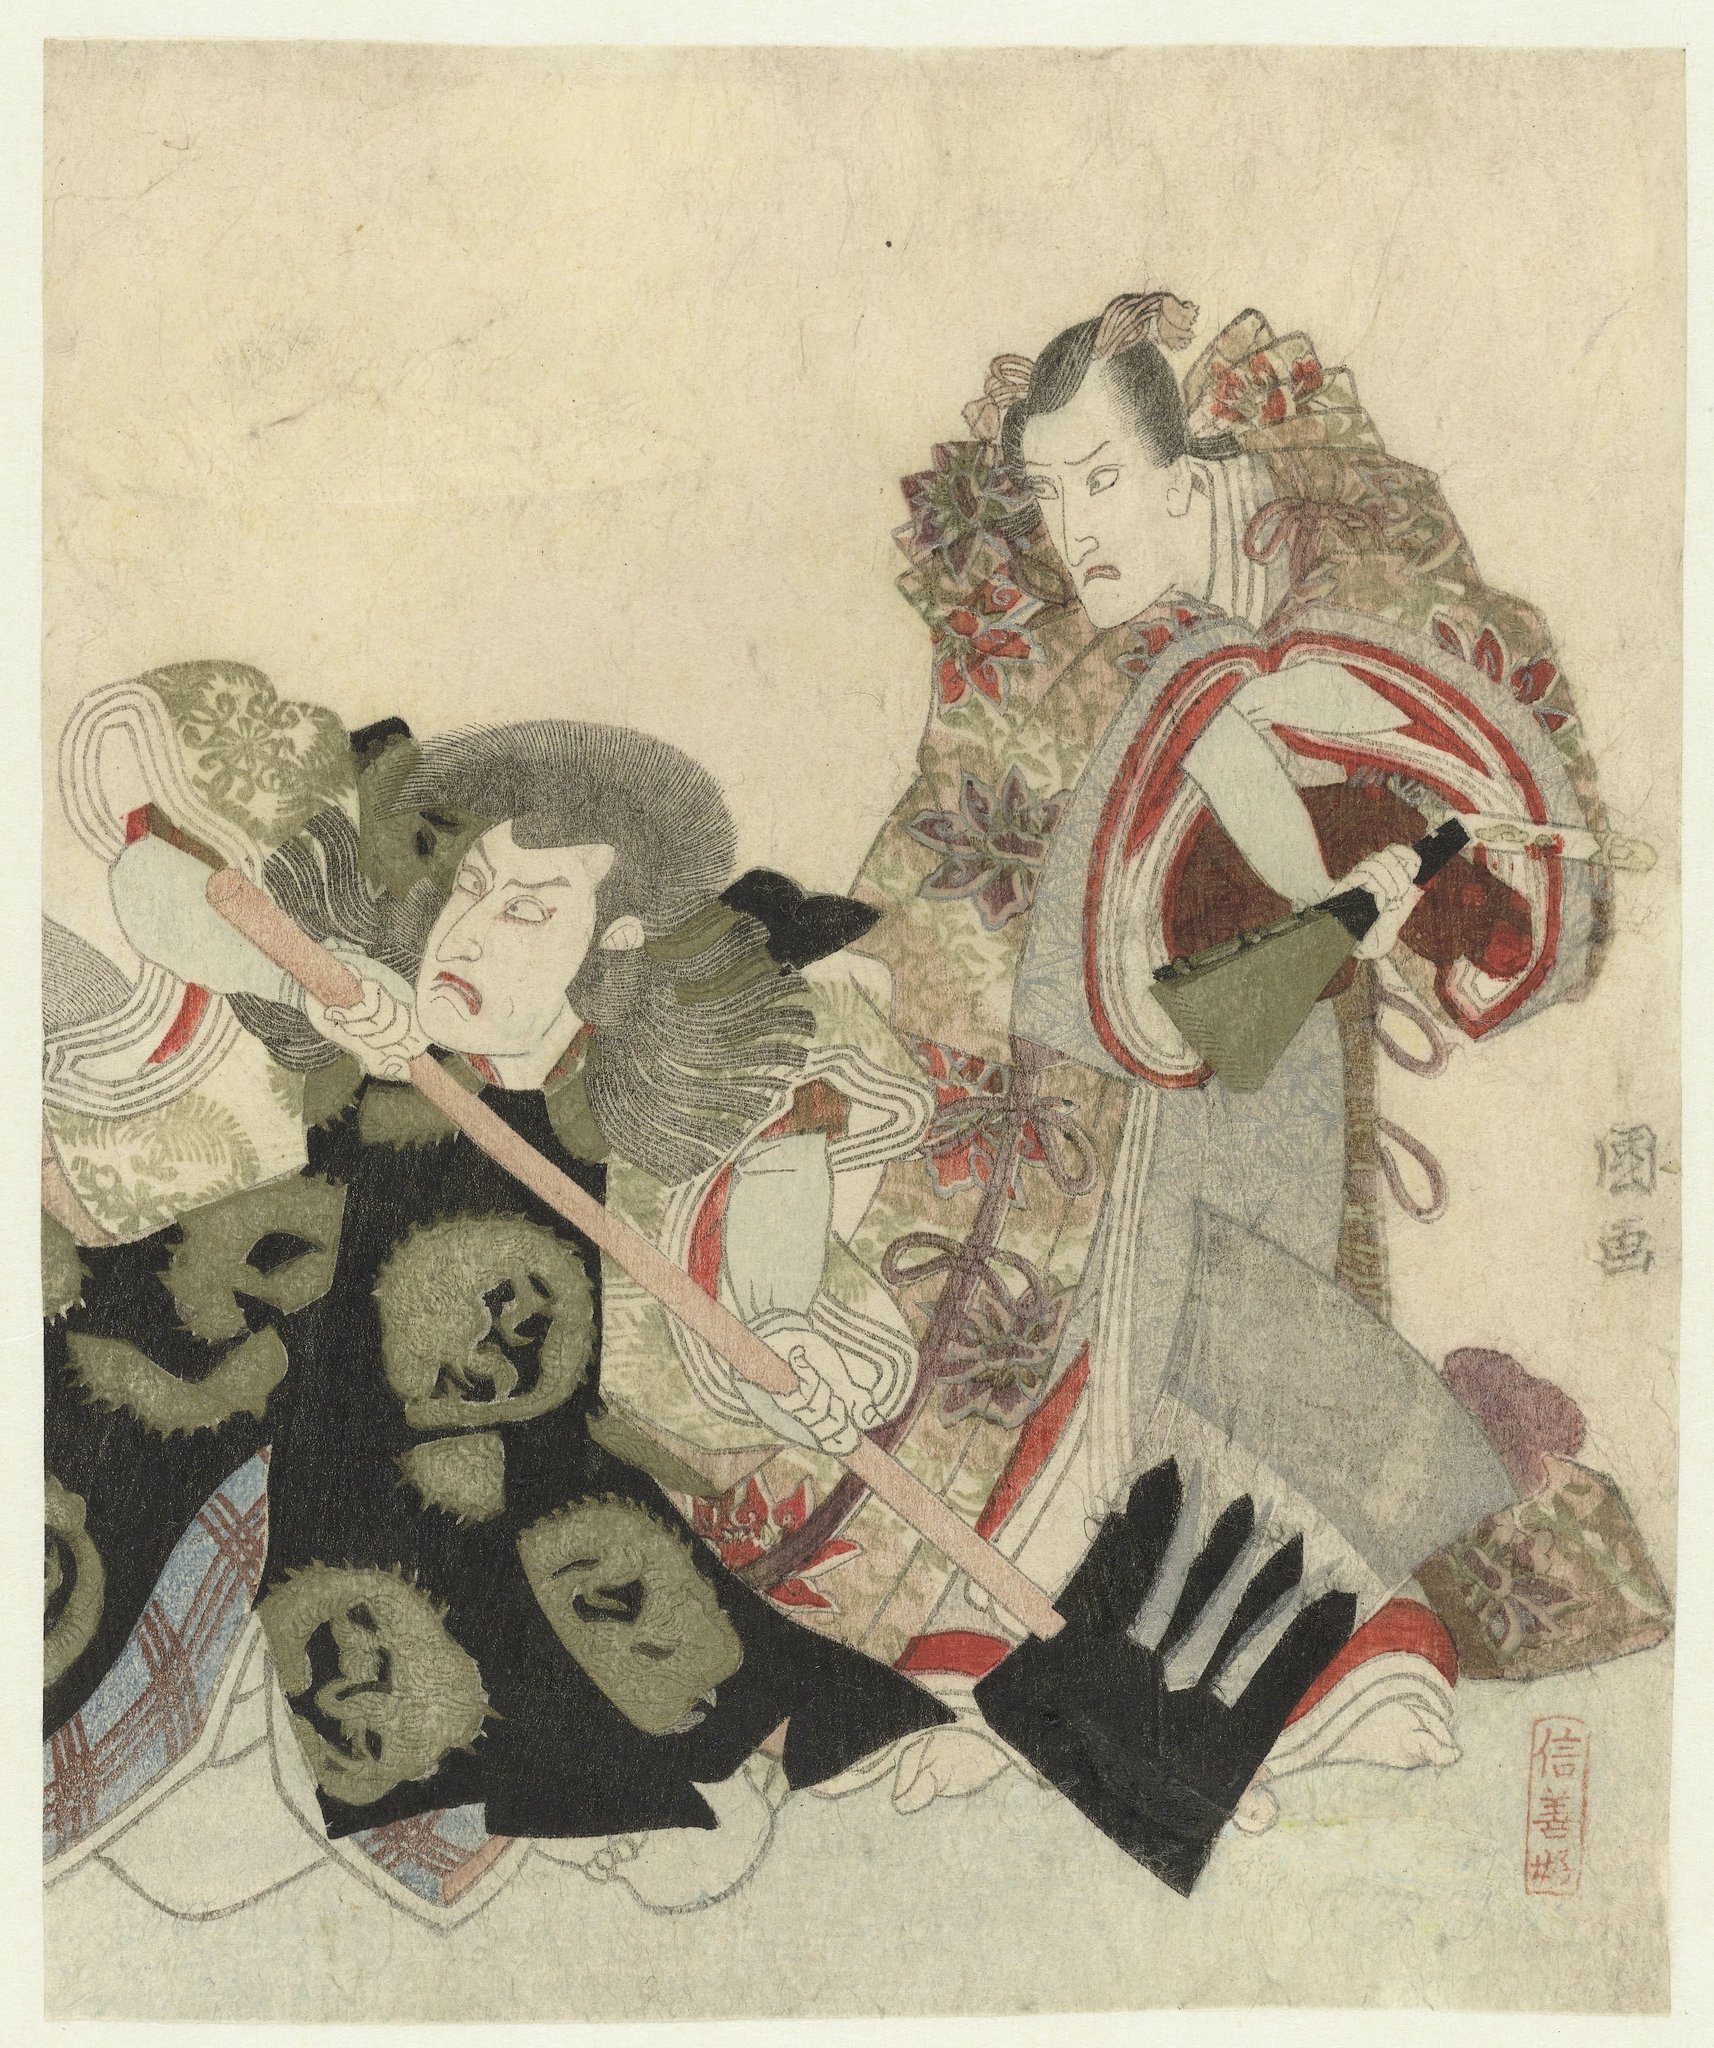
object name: print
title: Ichikawa Danjûrô VII als Yoshimune no Munesada met waaier en Ichikawa Omezô in de rol van Sekibei met bijl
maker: utagawa toyokuni (i)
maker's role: print maker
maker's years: 1769-1825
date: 1822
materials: paper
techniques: blind stamped, woodcut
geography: japan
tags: weapons, portrait of actor, actress, actor (on the stage)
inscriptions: collector's mark, verso, stamped: Lugt 2228, collector's mark, passe-partout, bottom left, printed: JABdH with a rooster.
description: Een surimono is een luxe uitgevoerde prent waarop beeld met één of meerdere gedichten gecombineerd is. Bij het drukken van een surimono werd vaak gebruik gemaakt van dikker papier, blinddruk en metaal pigmenten, zoals koper- en zilverpoeder. De prenten werden vaak in opdracht van dichters gemaakt en als exclusief geschenk aan vrienden en relaties gegeven.